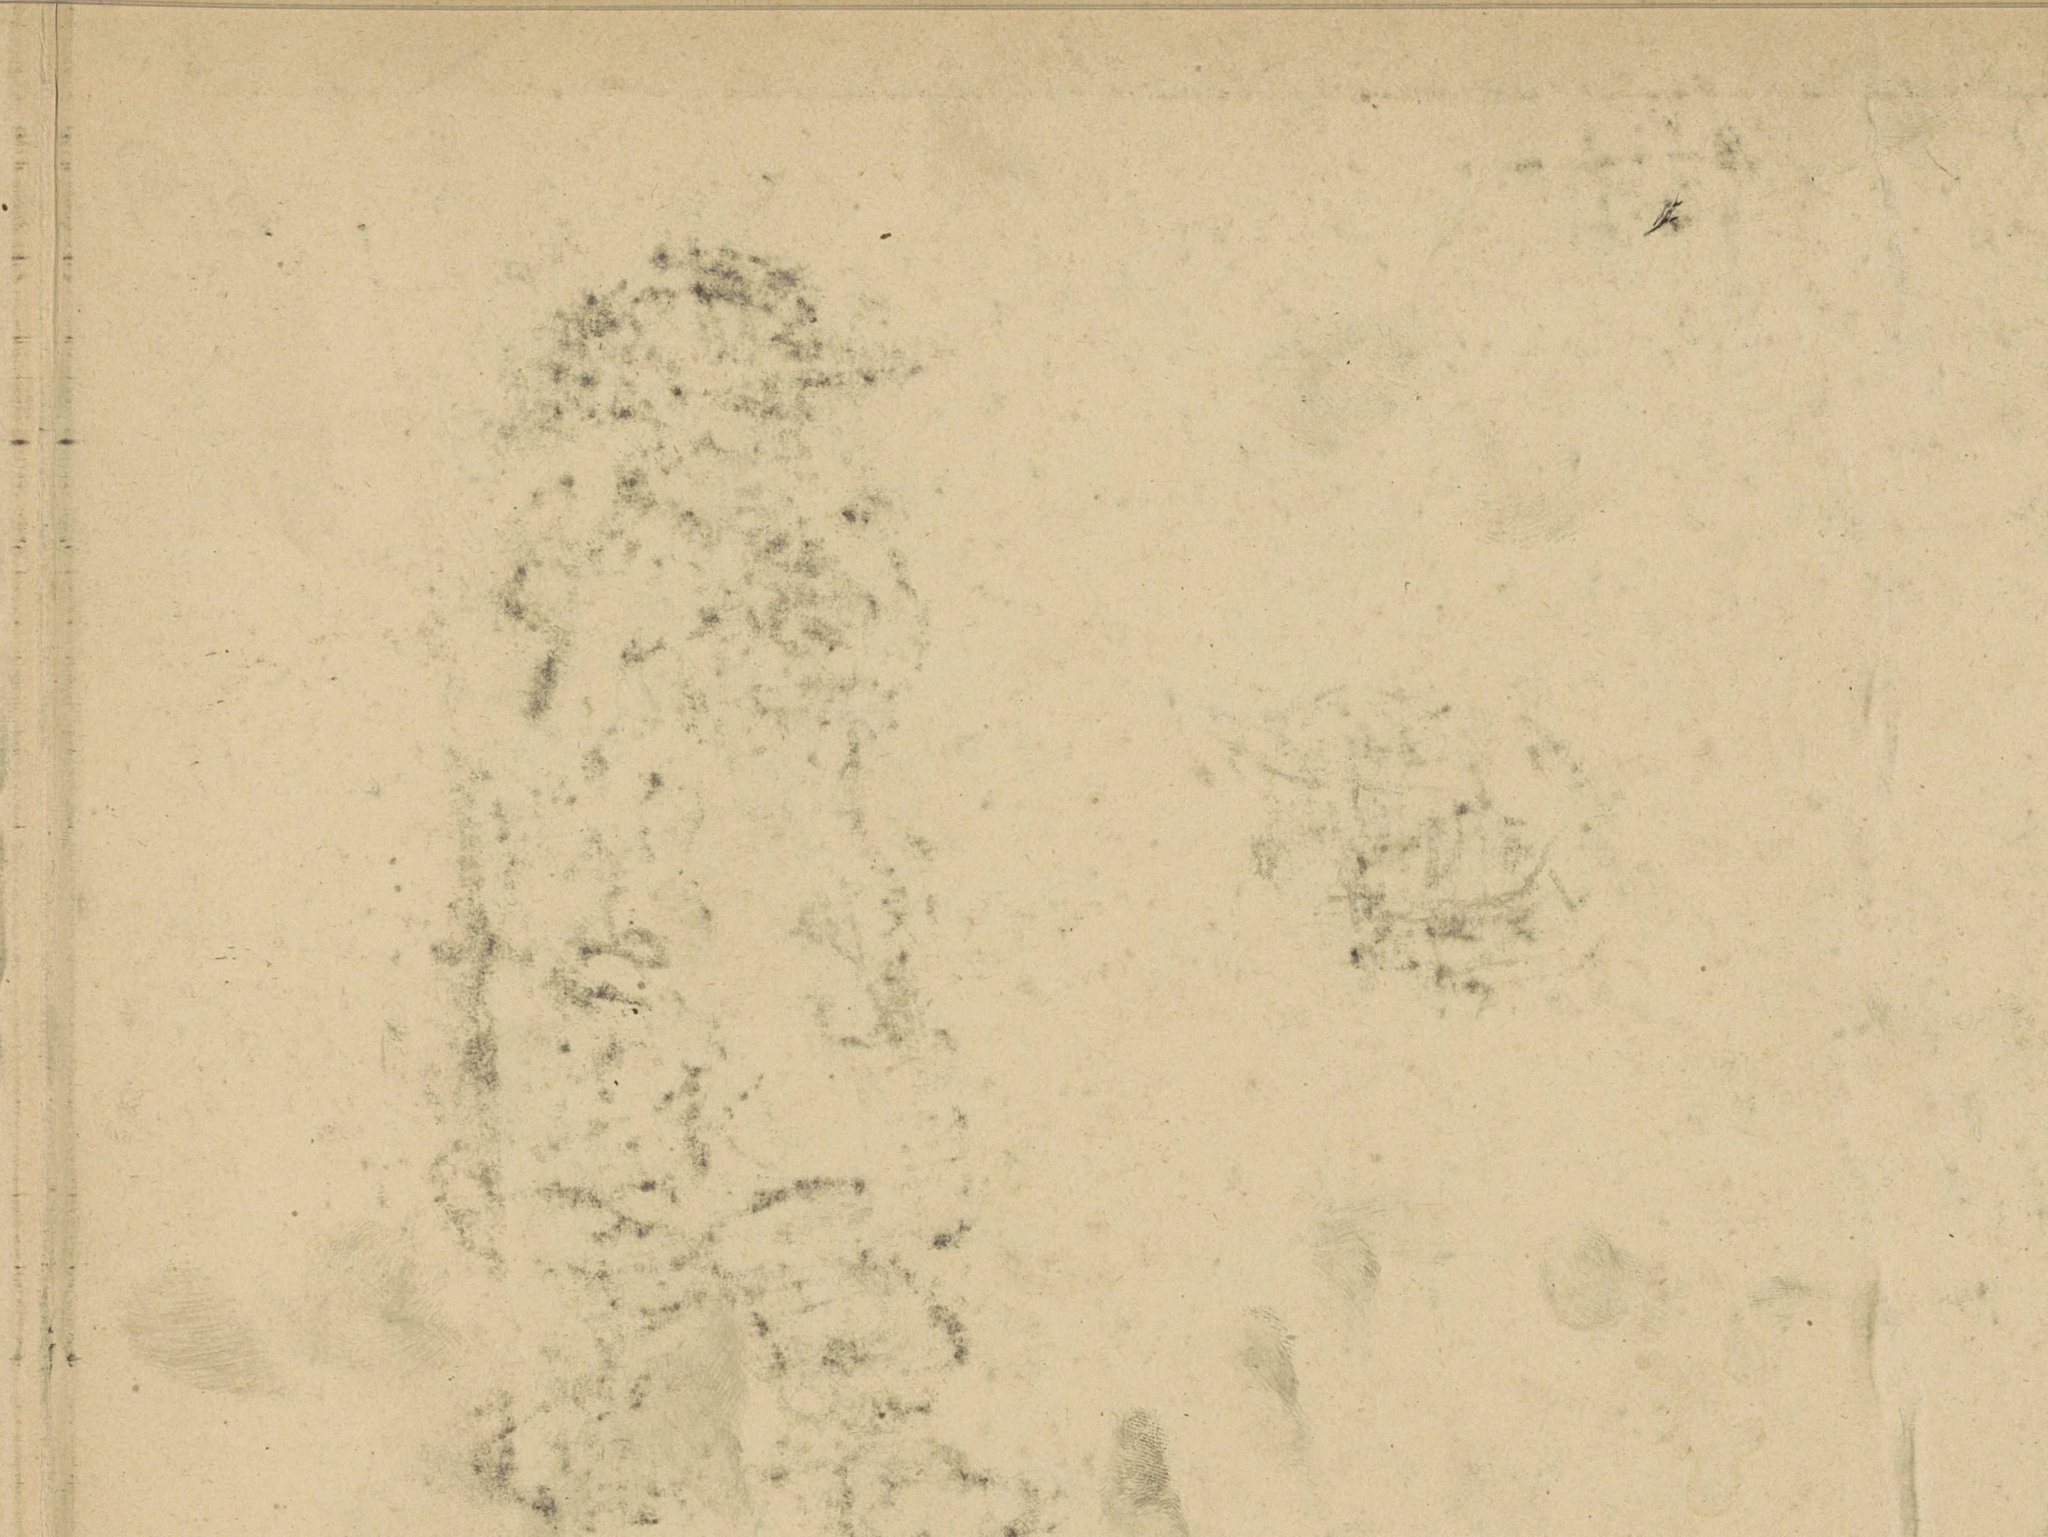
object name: endleaf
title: Abklatsch van de krijttekening op blad 17 verso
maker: isaac israels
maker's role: draughtsman, painter, print maker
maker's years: 1865-1934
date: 1875-1934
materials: paper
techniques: printmaking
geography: the hague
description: Schutblad B, achterste schutblad, uit schetsboek XIV met 17 bladen.